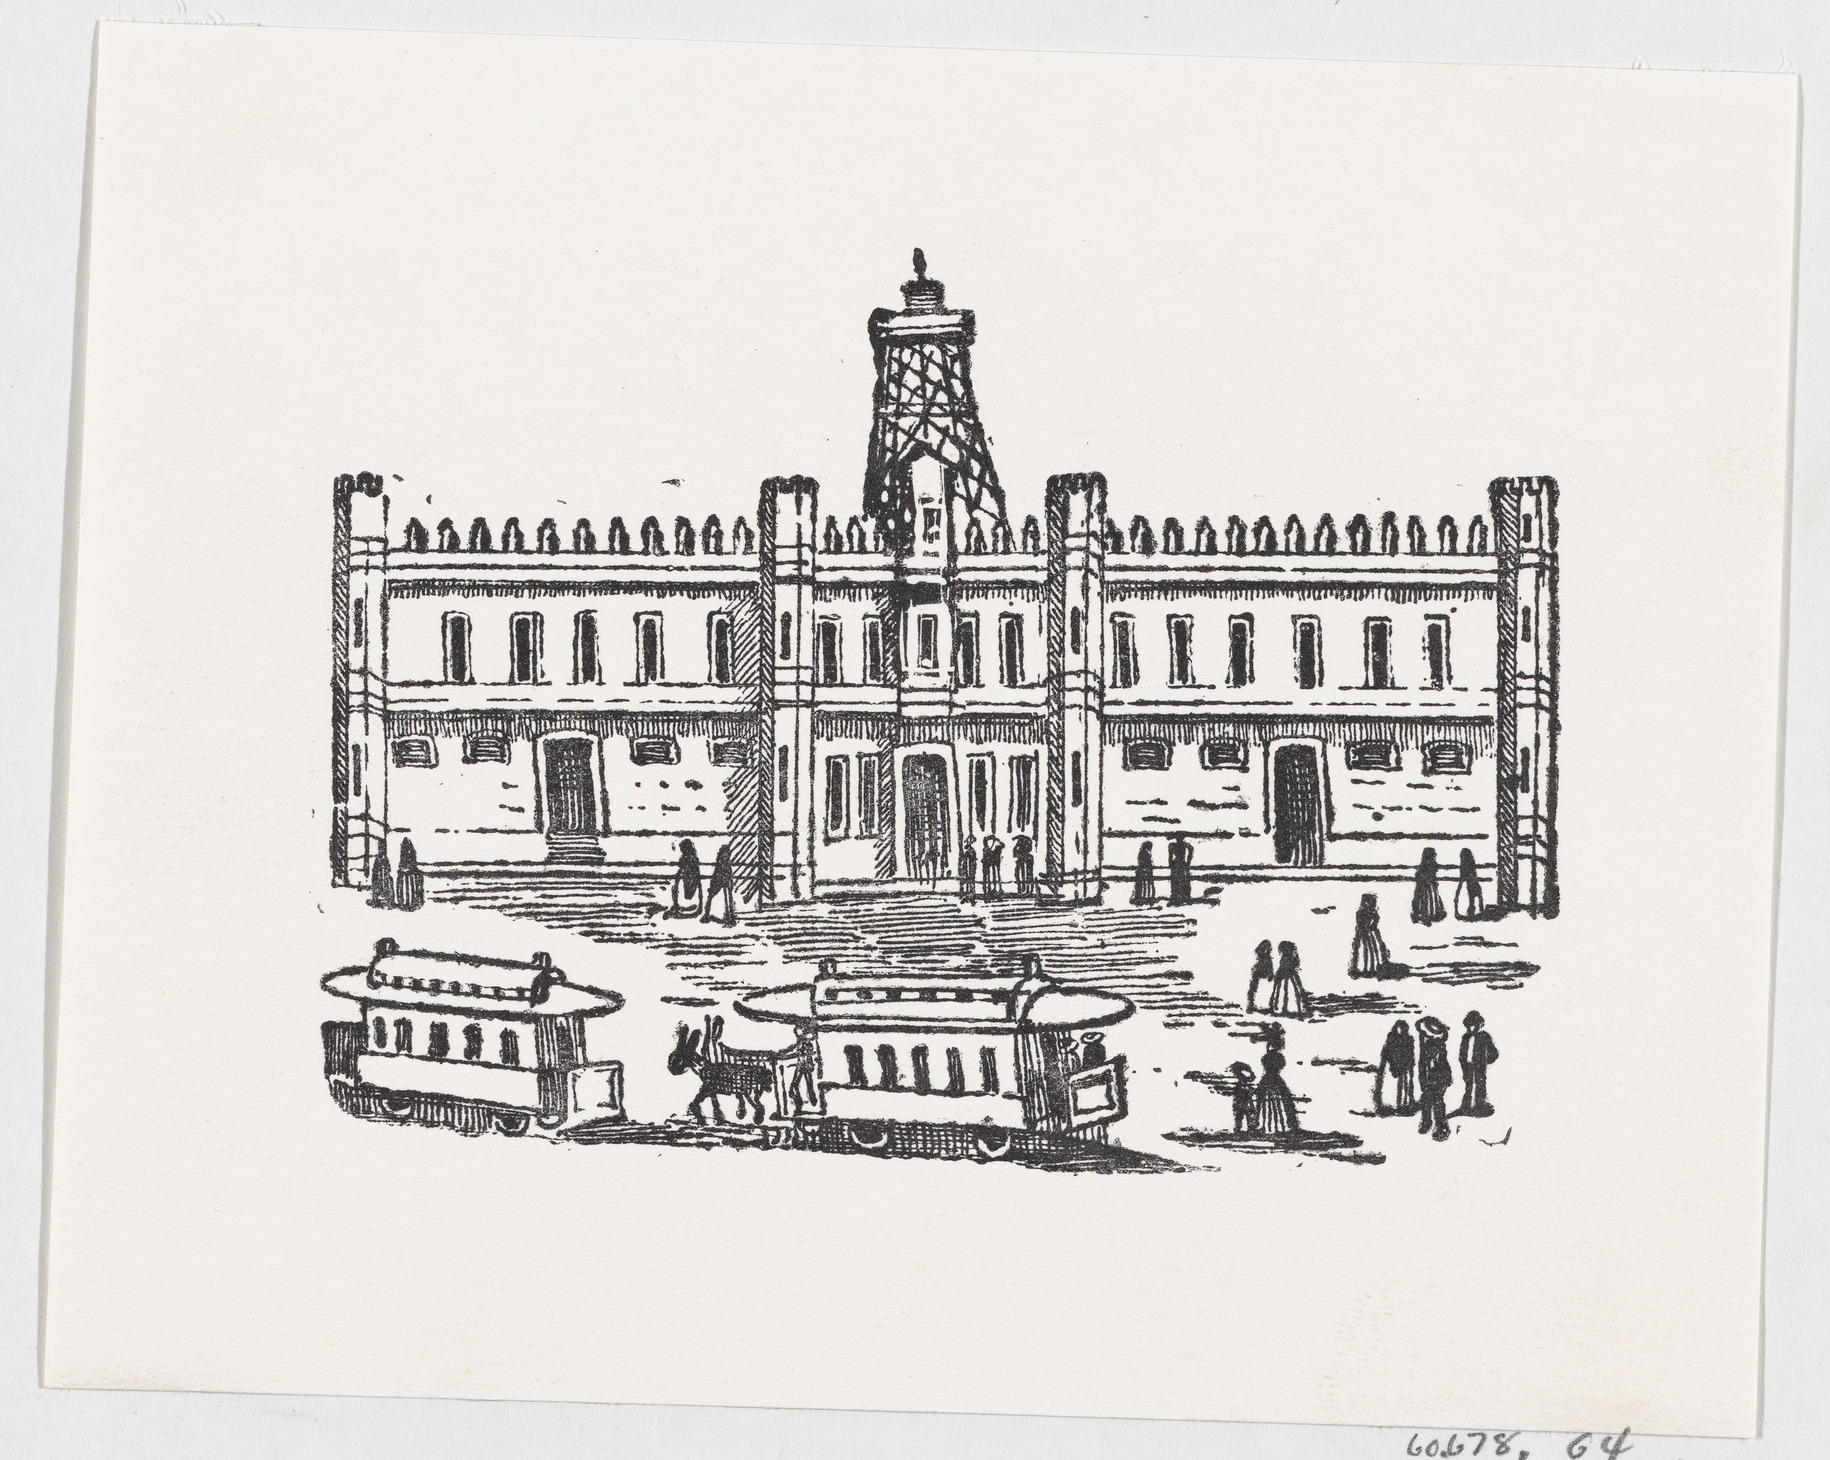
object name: print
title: Carriages and people in a town square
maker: josé guadalupe posada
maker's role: artist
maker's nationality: mexican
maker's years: 1852-1913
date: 1880-1910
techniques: lithography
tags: human figures,towns,carriages